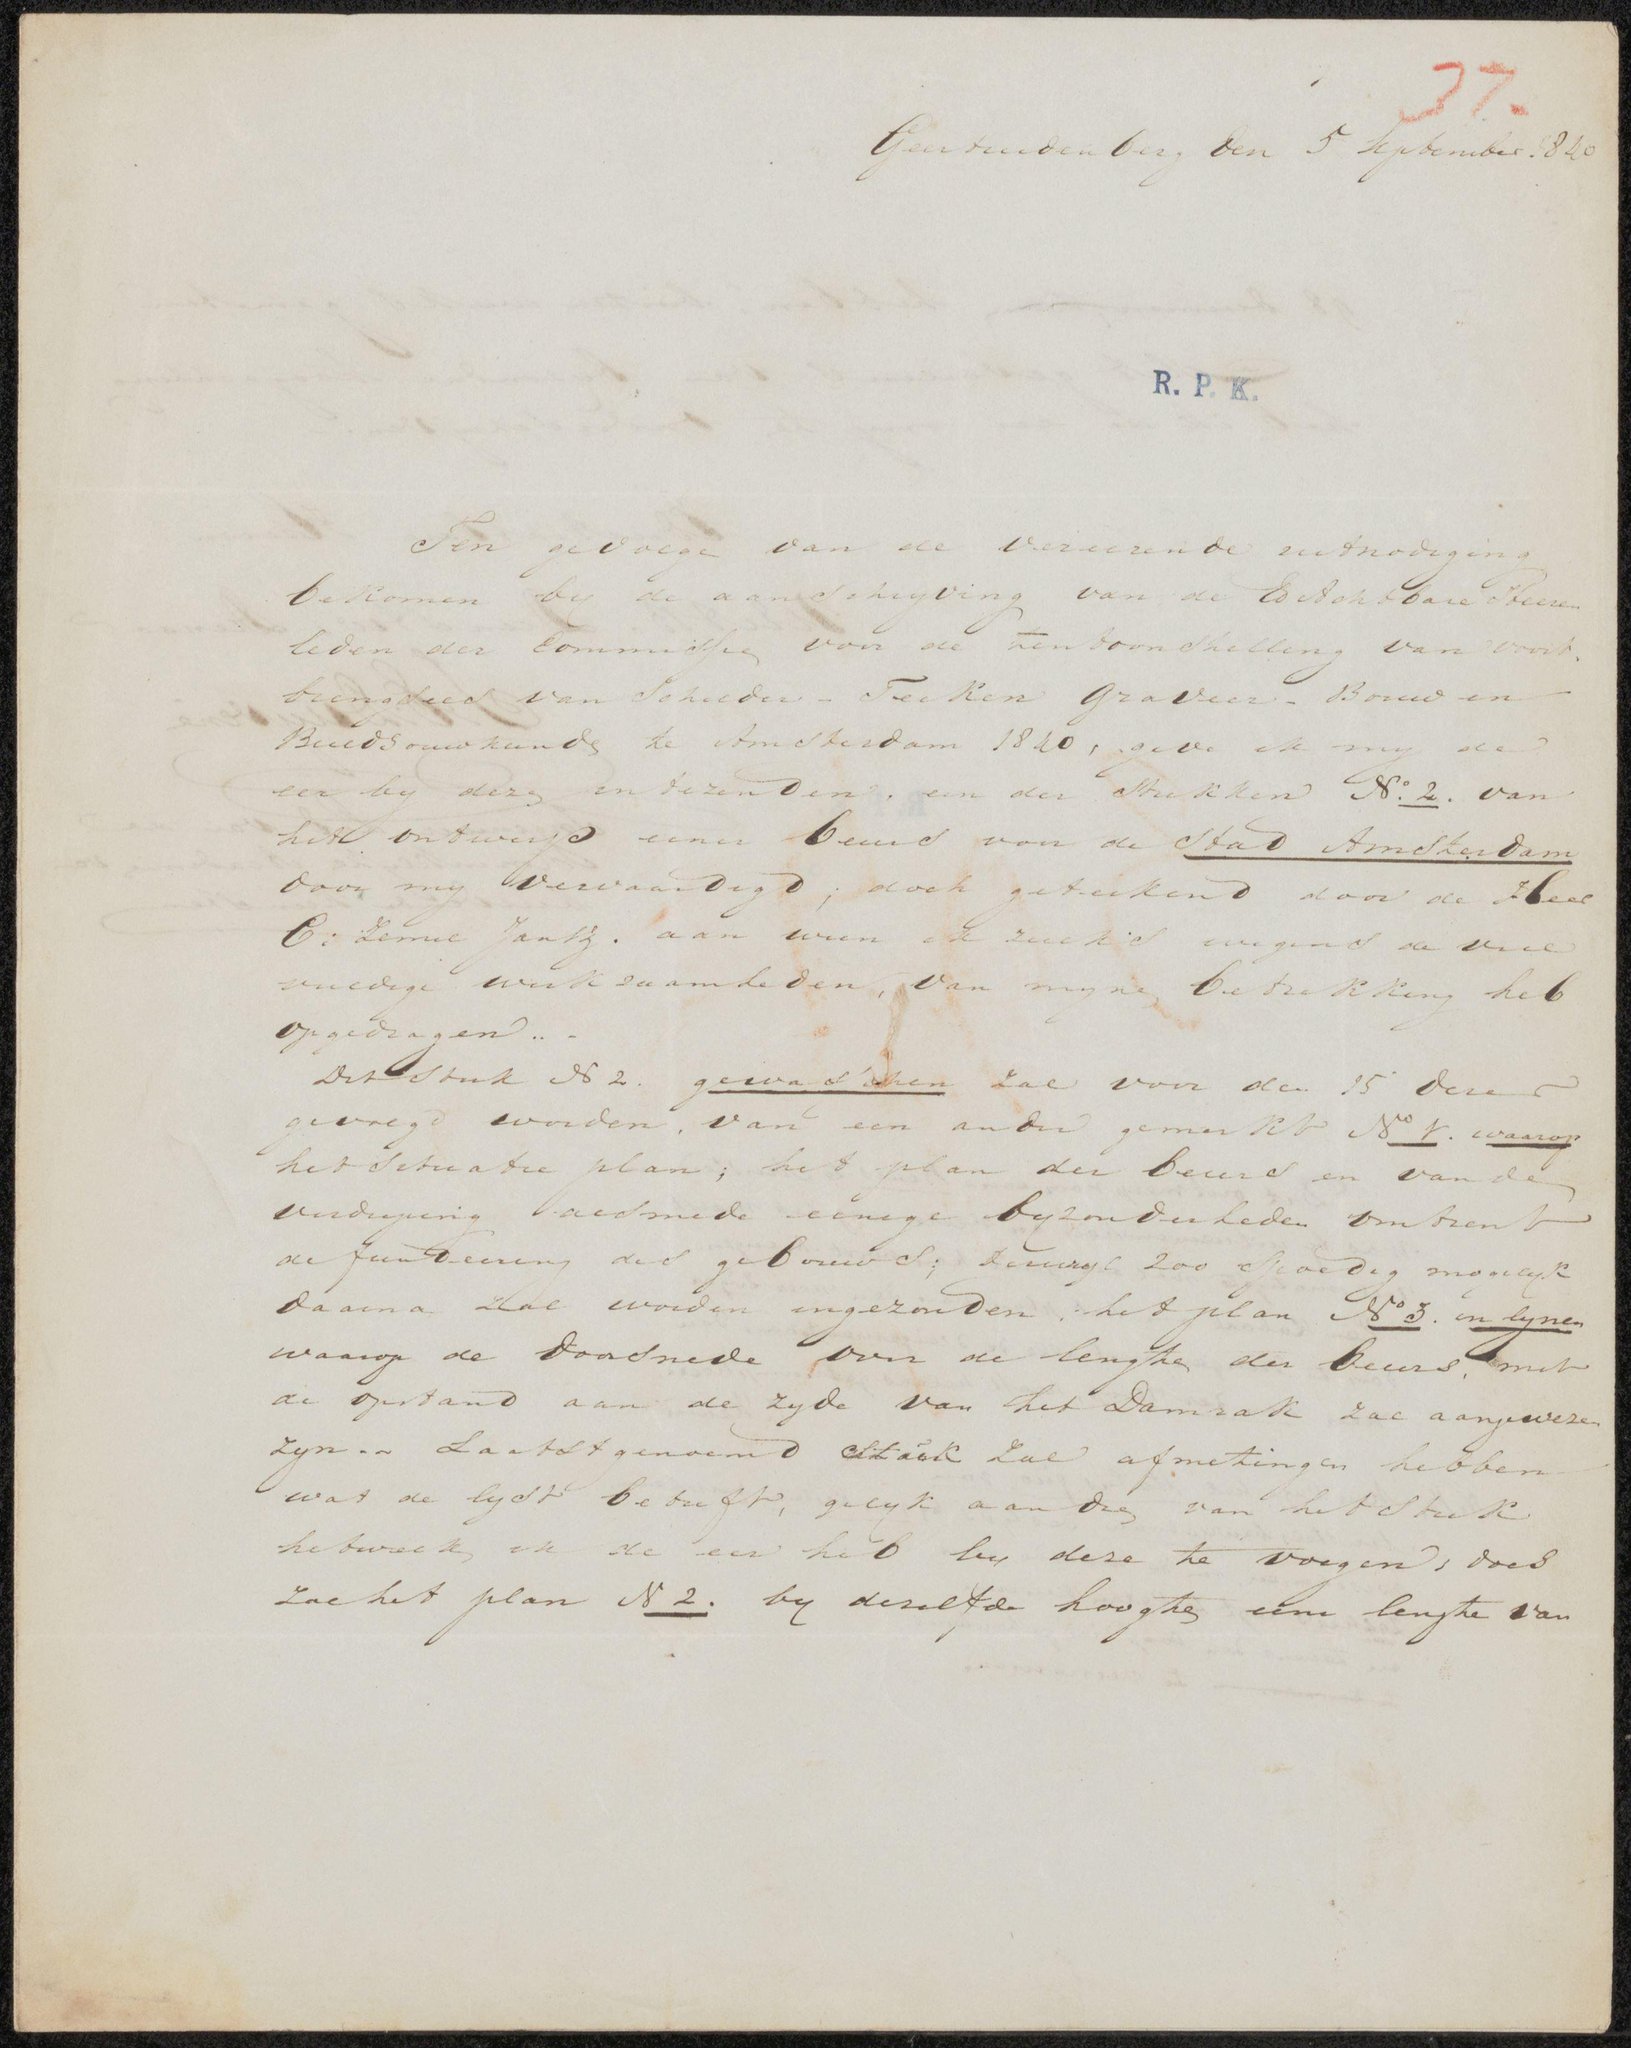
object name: letter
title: Brief aan de commissie van de Tentoonstelling van Levende Meesters in Amsterdam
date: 1840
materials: ink, paper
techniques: pen, writing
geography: geertruidenberg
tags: politician, adriaan van der hoop, drawing, architecture, exhibition ~ art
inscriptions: collector's mark: Lugt 2233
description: Brief bevat aantekening van Christiaan Kramm.